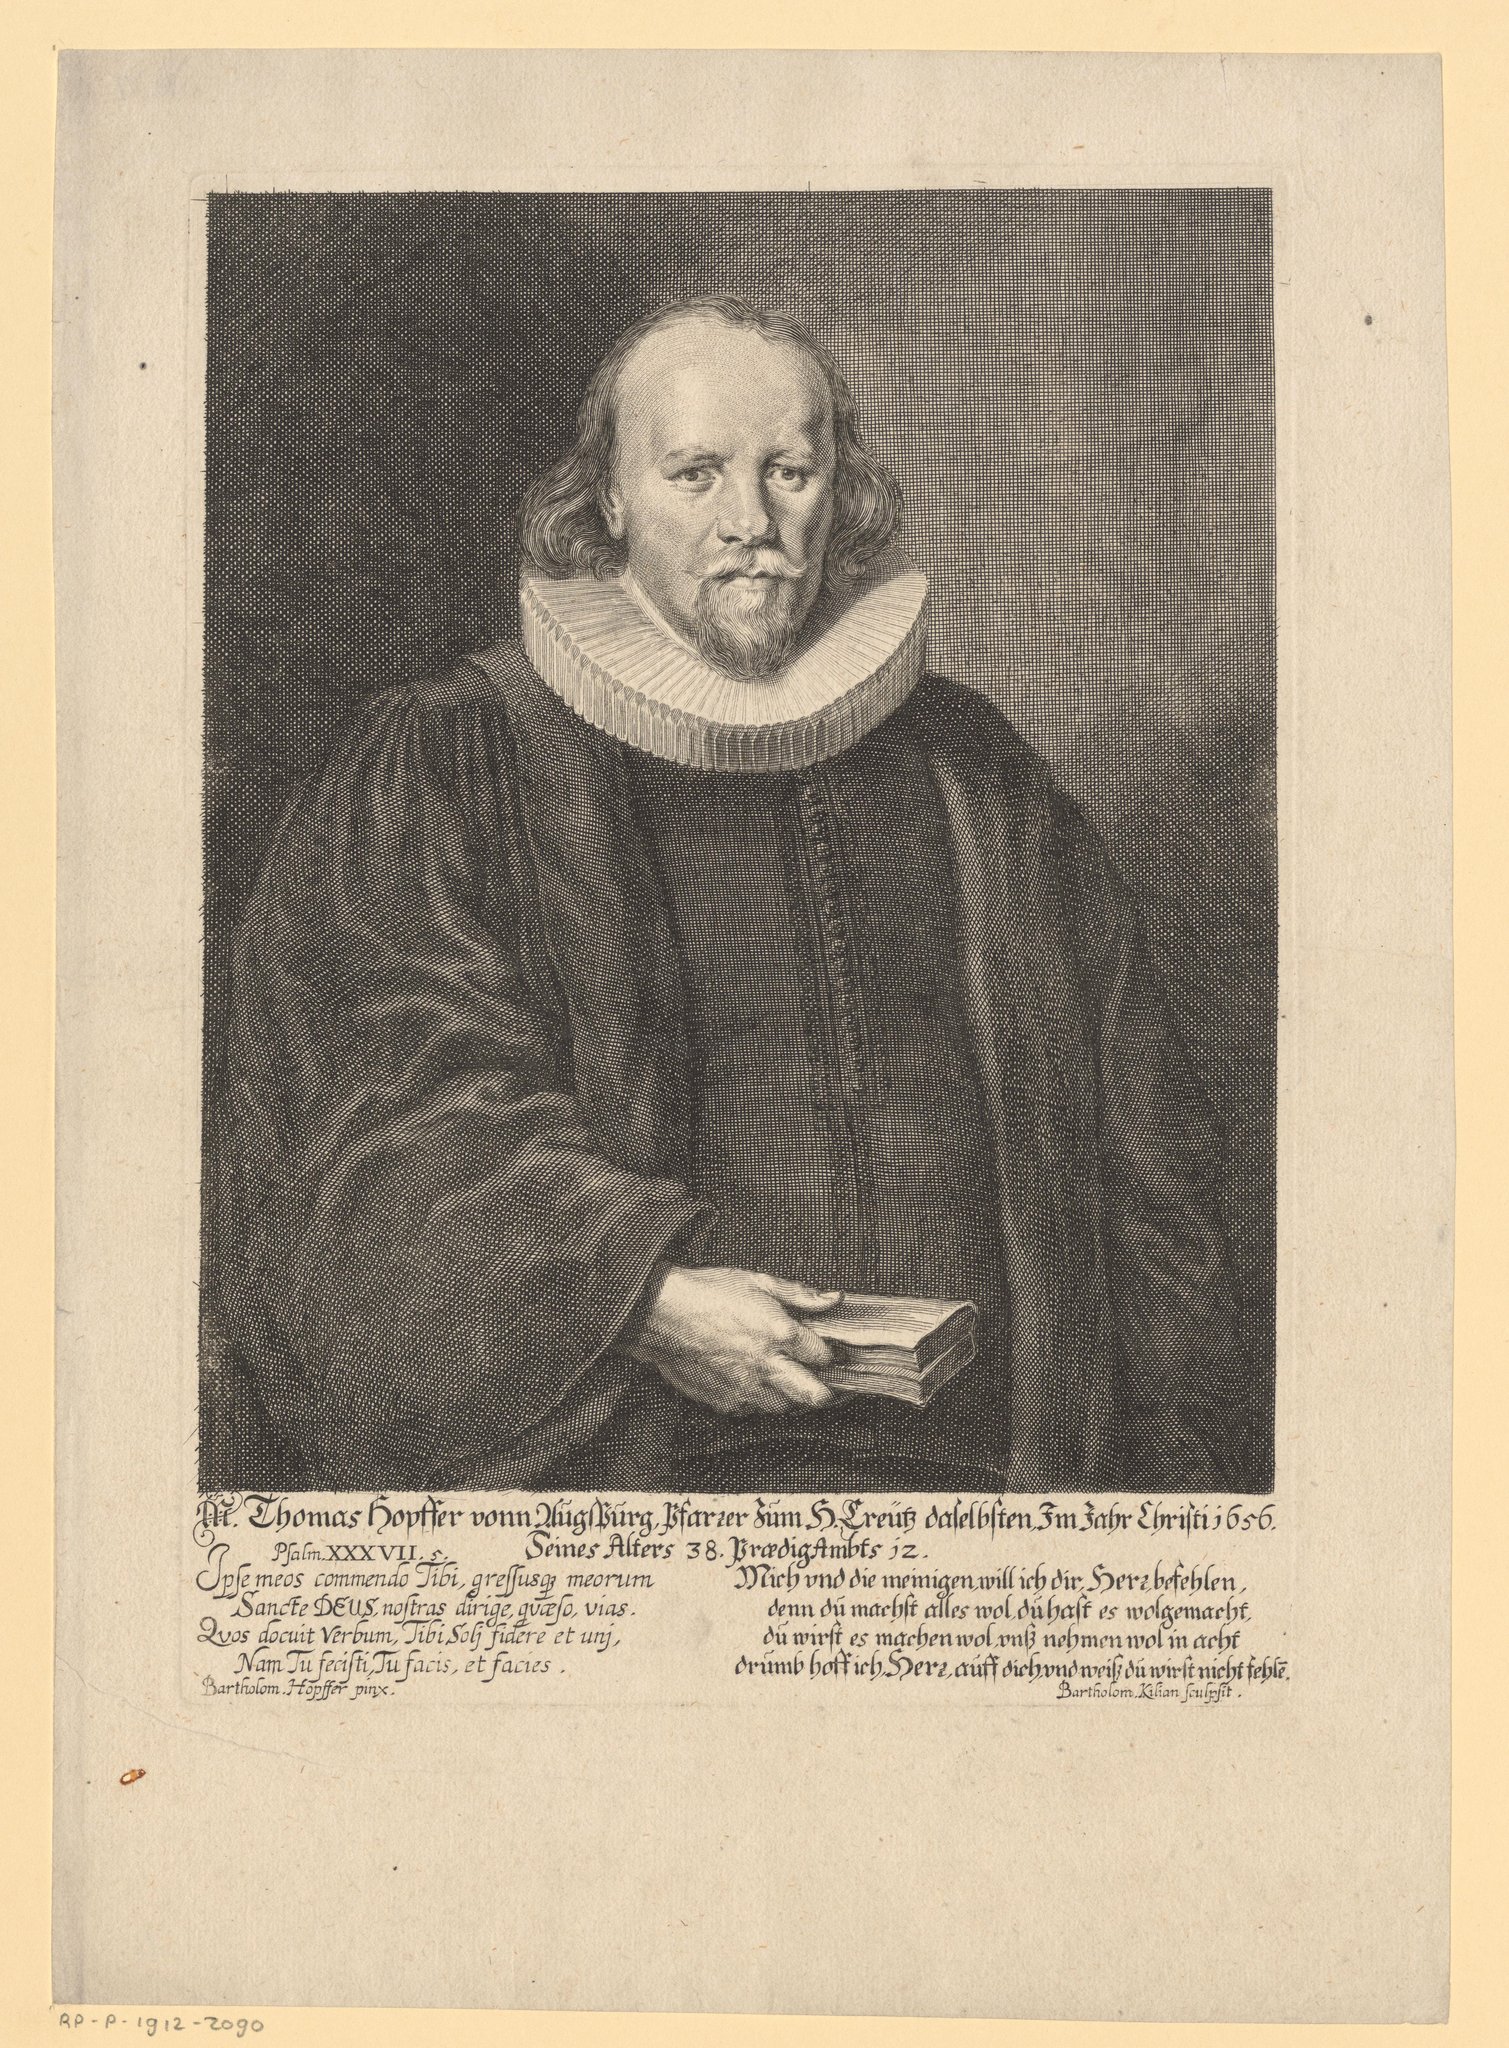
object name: print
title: Portret van Thomas Hopffer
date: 1656-1696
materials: paper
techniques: engraving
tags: augsburg, theologian, historical persons, book